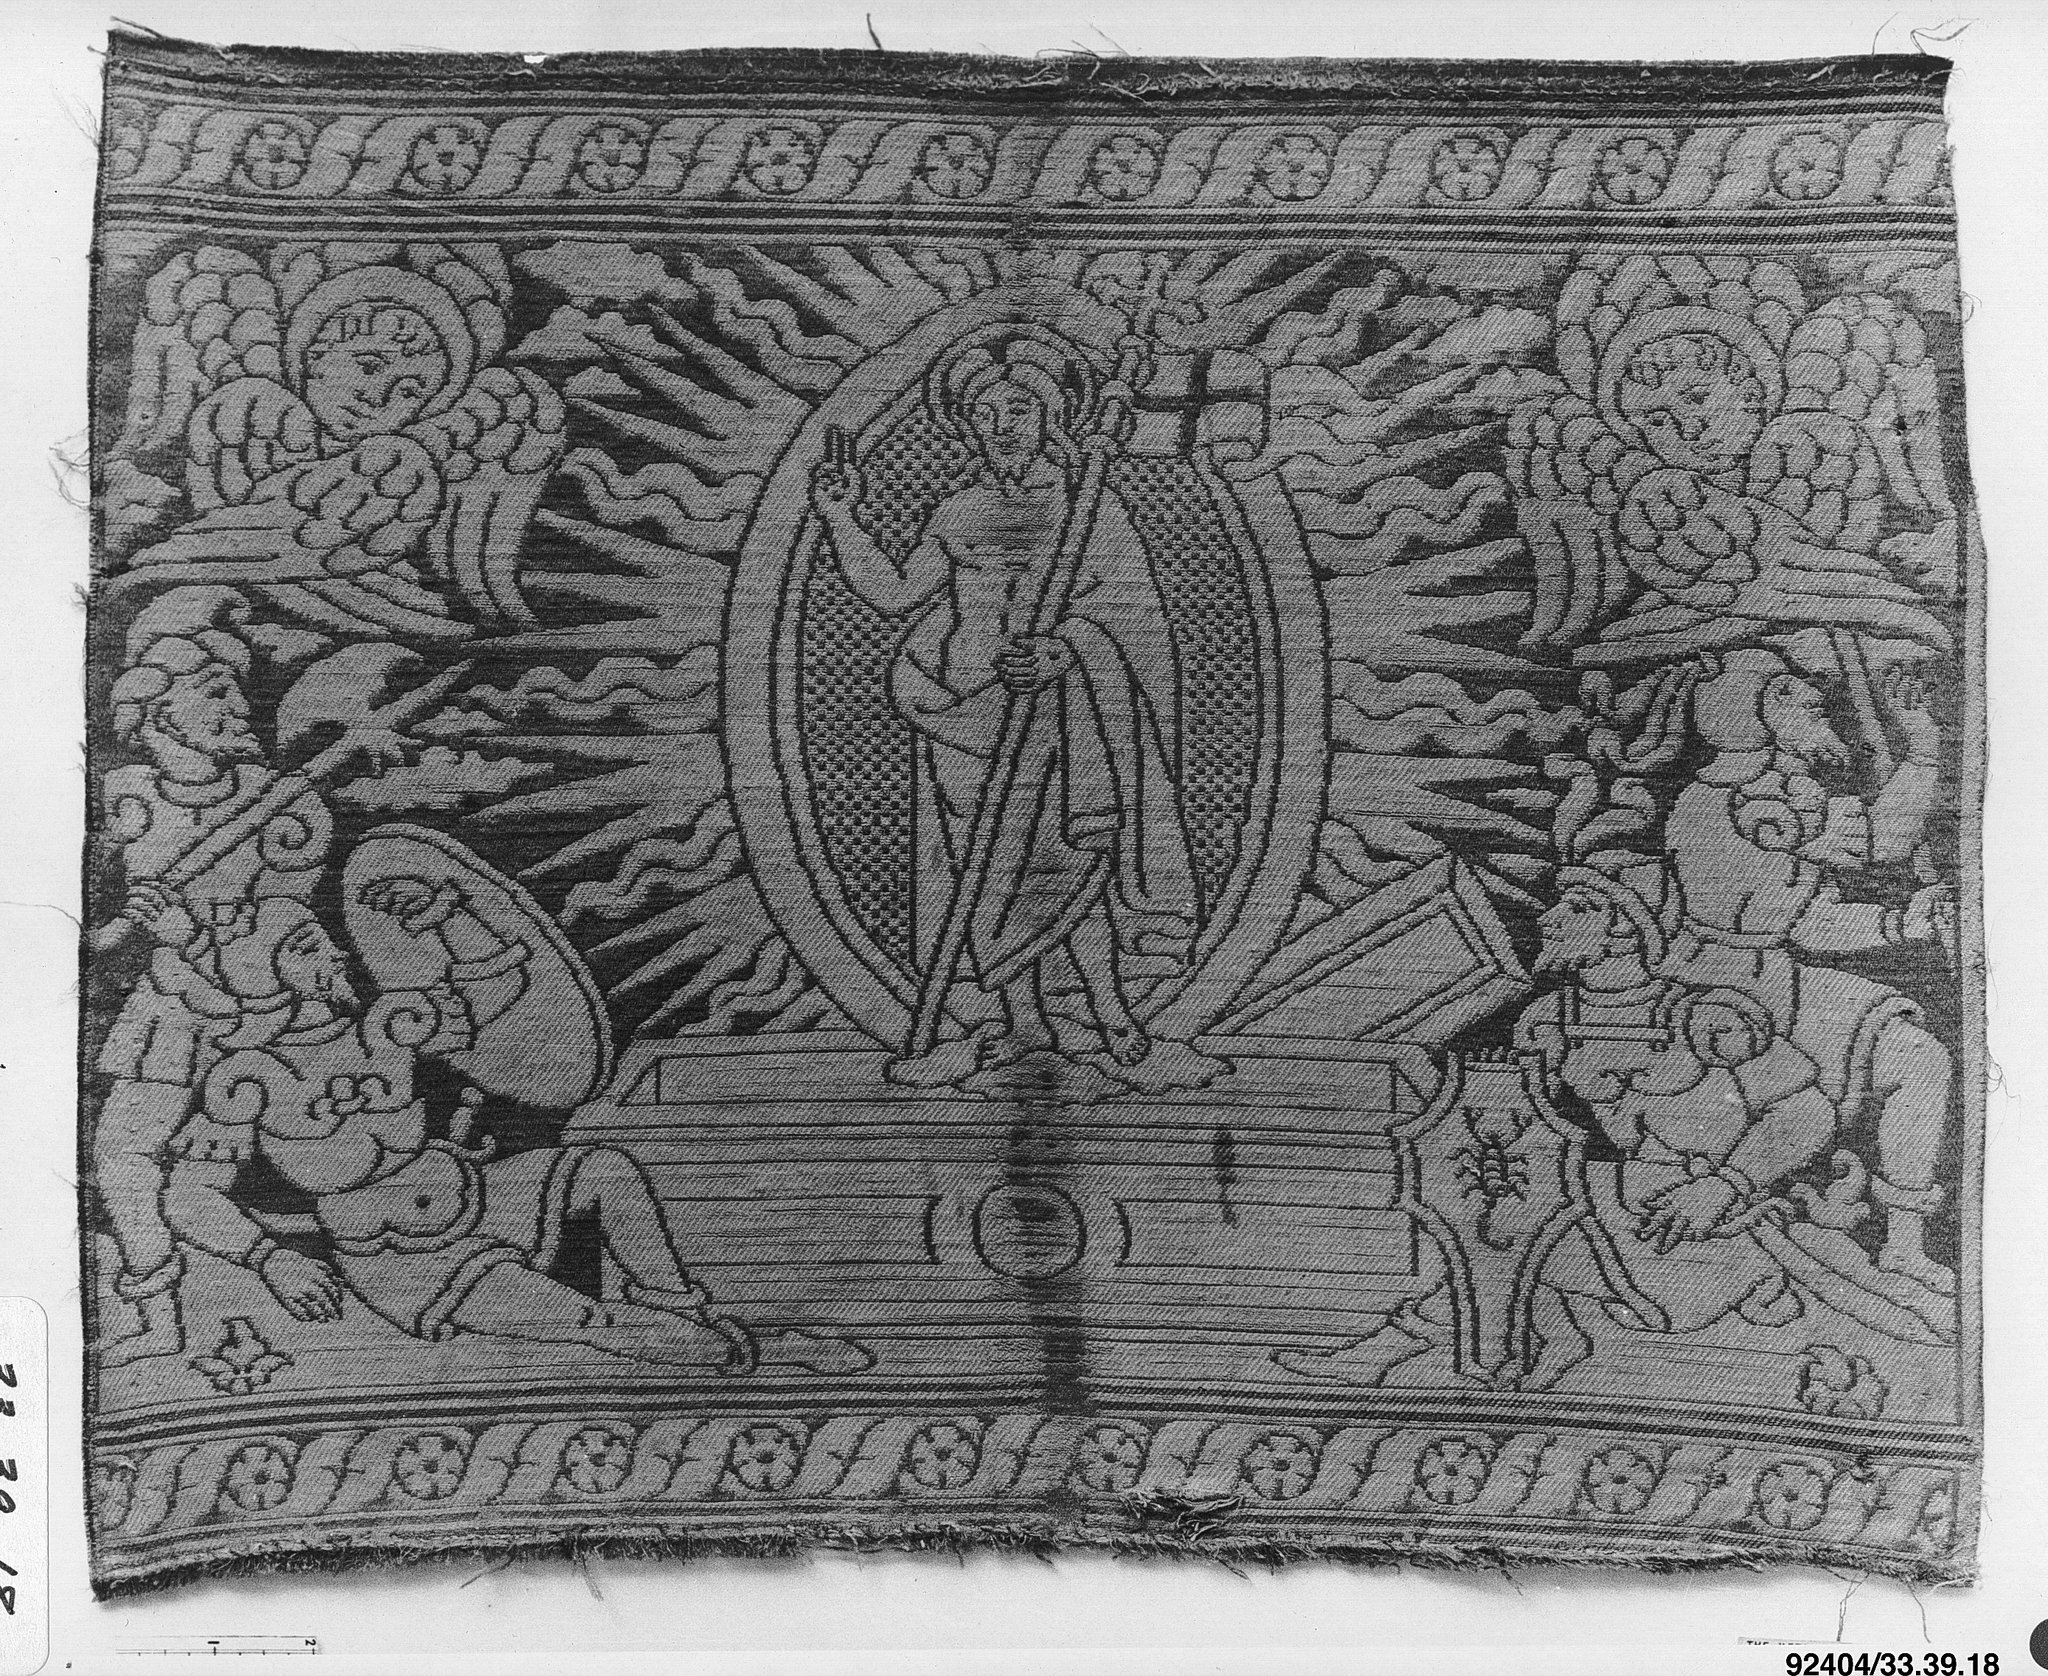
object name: clothing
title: Apparel for a vestment woven with figurative design of the Resurrected Christ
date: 1401-1600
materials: linen, silk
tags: men,angels,christ